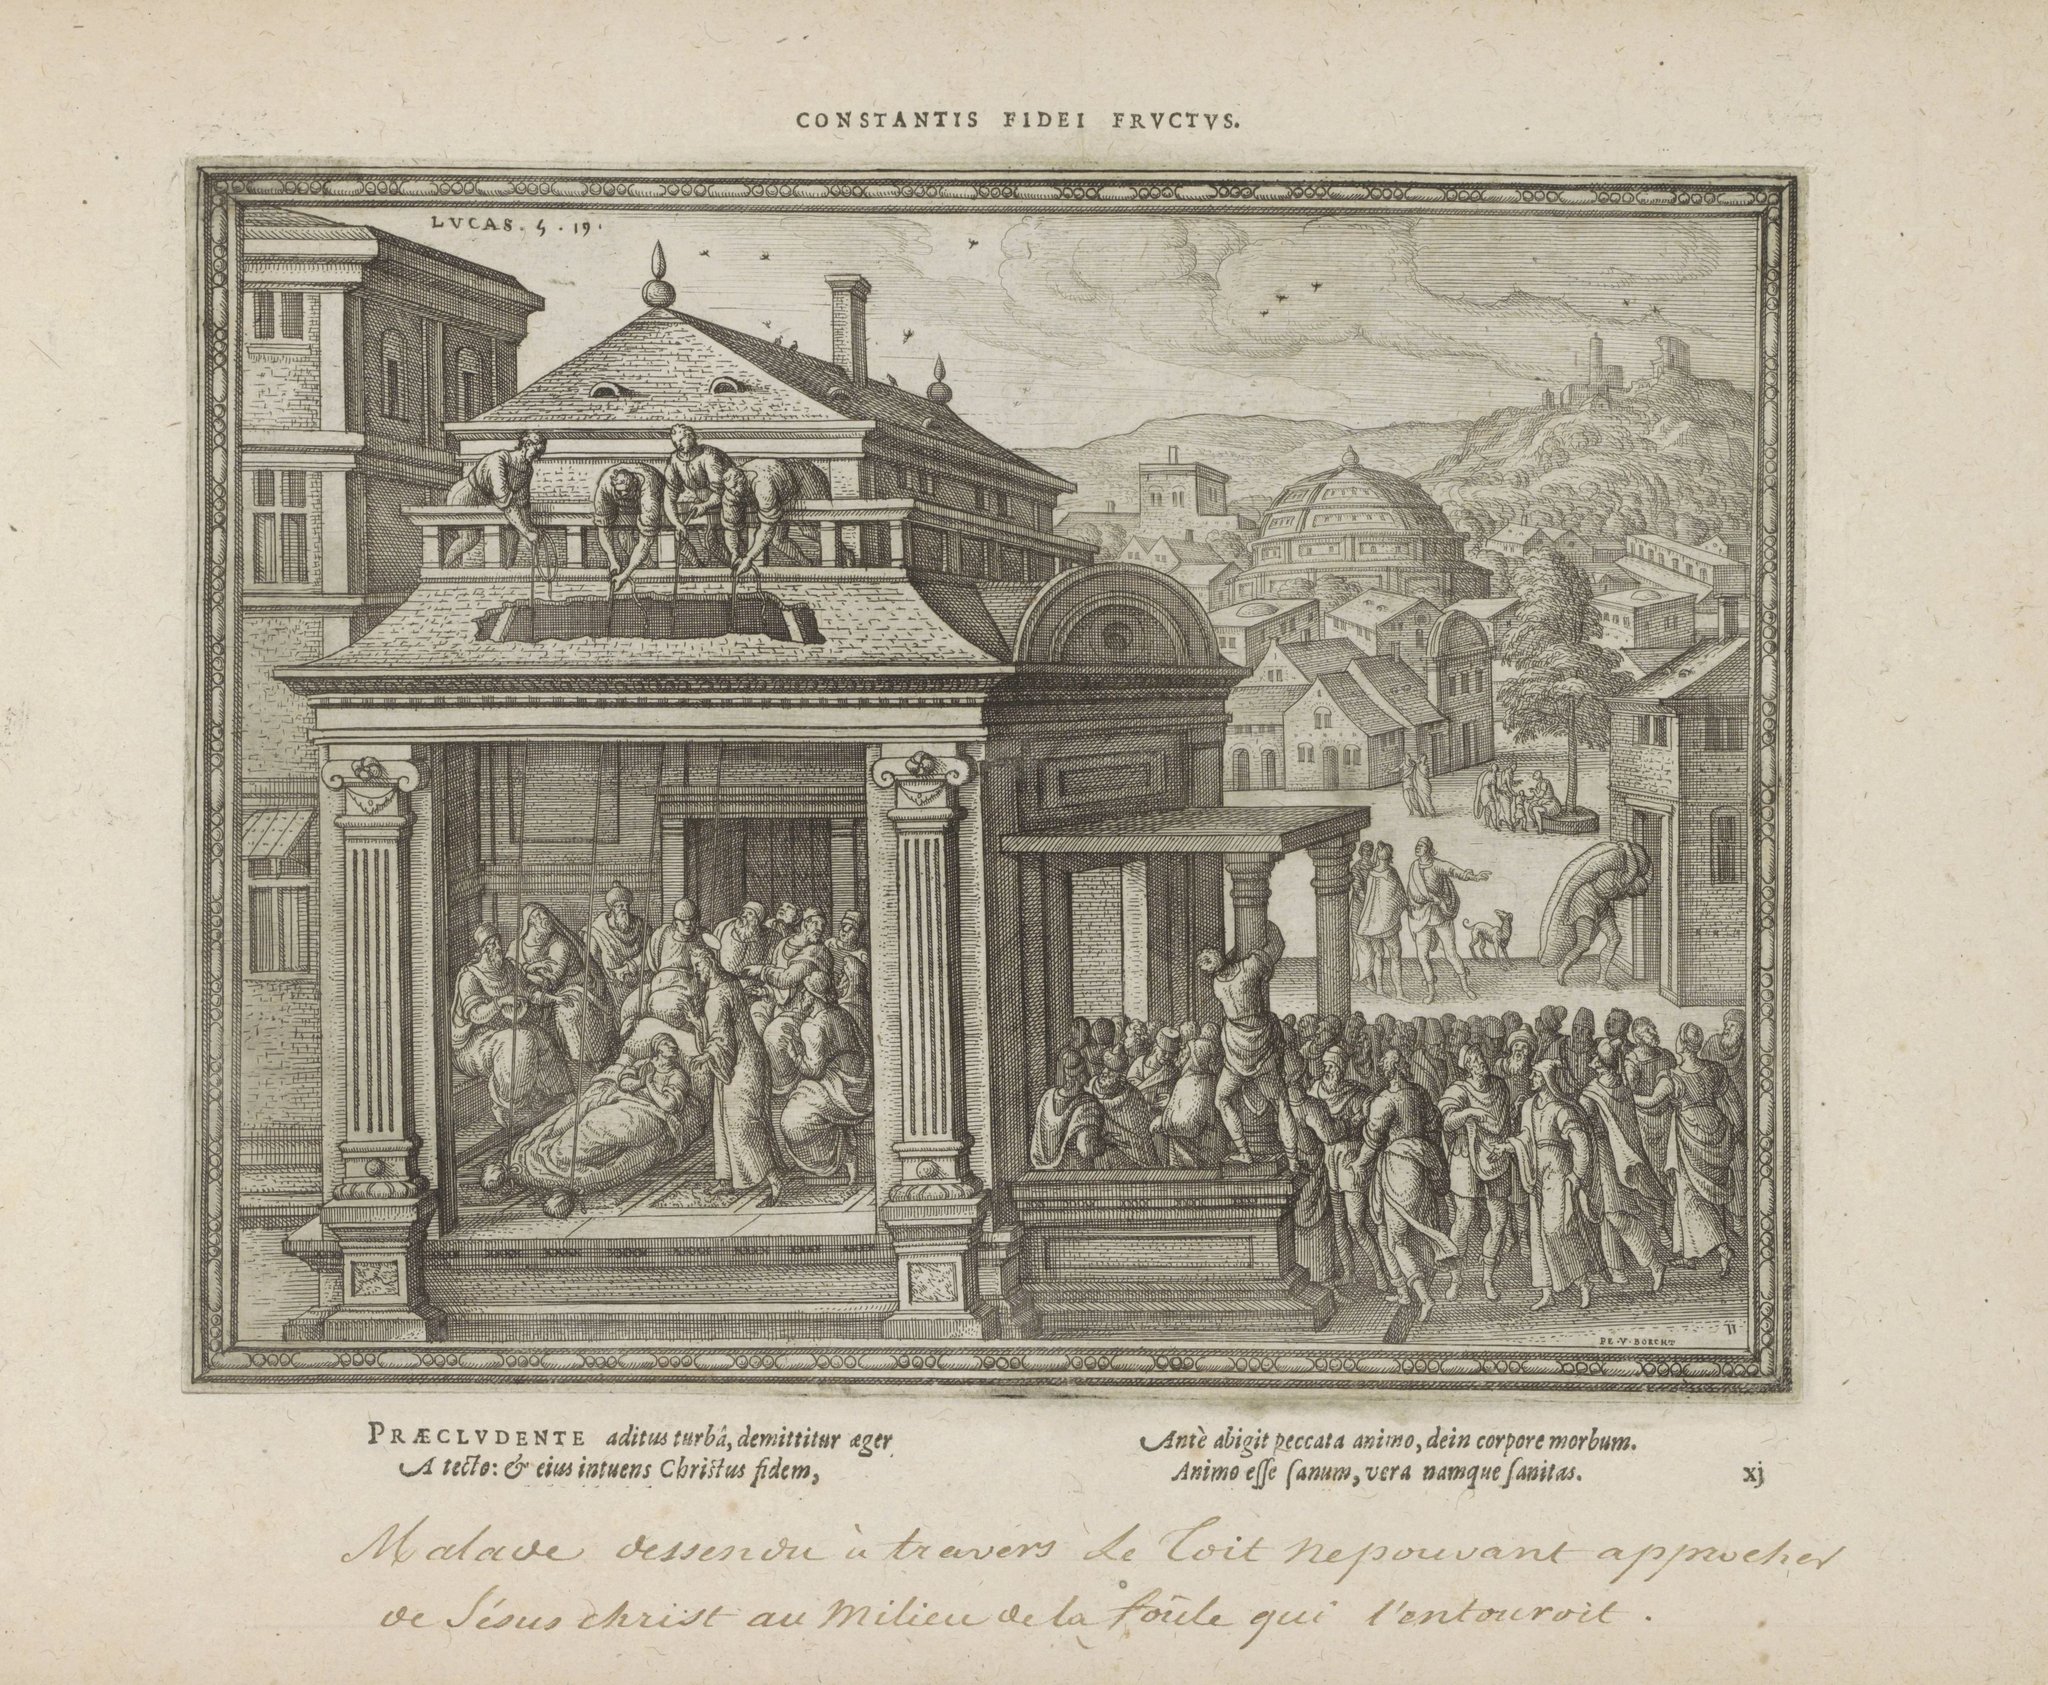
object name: album leaf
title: Imagines et figurae bibliorum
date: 1582-1593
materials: paper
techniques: etching, letterpress printing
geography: antwerp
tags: the paralytic takes up his bed and walks away ~ christ healing paralytics, christ says: 'my son, your sins are forgiven' ~ christ healing paralytics, a paralytic is let down through the roof of the house where christ is preaching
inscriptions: inscription: ‘Malade dessendu à travers le loit nepouvant approcher de Jésus Christ au Milieu de la foule qui l'entouroit’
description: Vier mannen laten door het dak een verlamde man voor de voeten van Christus zakken. Christus vergeeft de zonden van de verlamde man en zegt hem zijn bed te pakken en te wandelen. Rechts loopt de man met zijn matras op zijn rug een huis binnen (Luc. 5:19). Met een motto in het Latijn boven de voorstelling en een vierregelig onderschrift in het Latijn onder de prent. De prent maakt deel uit van een album.